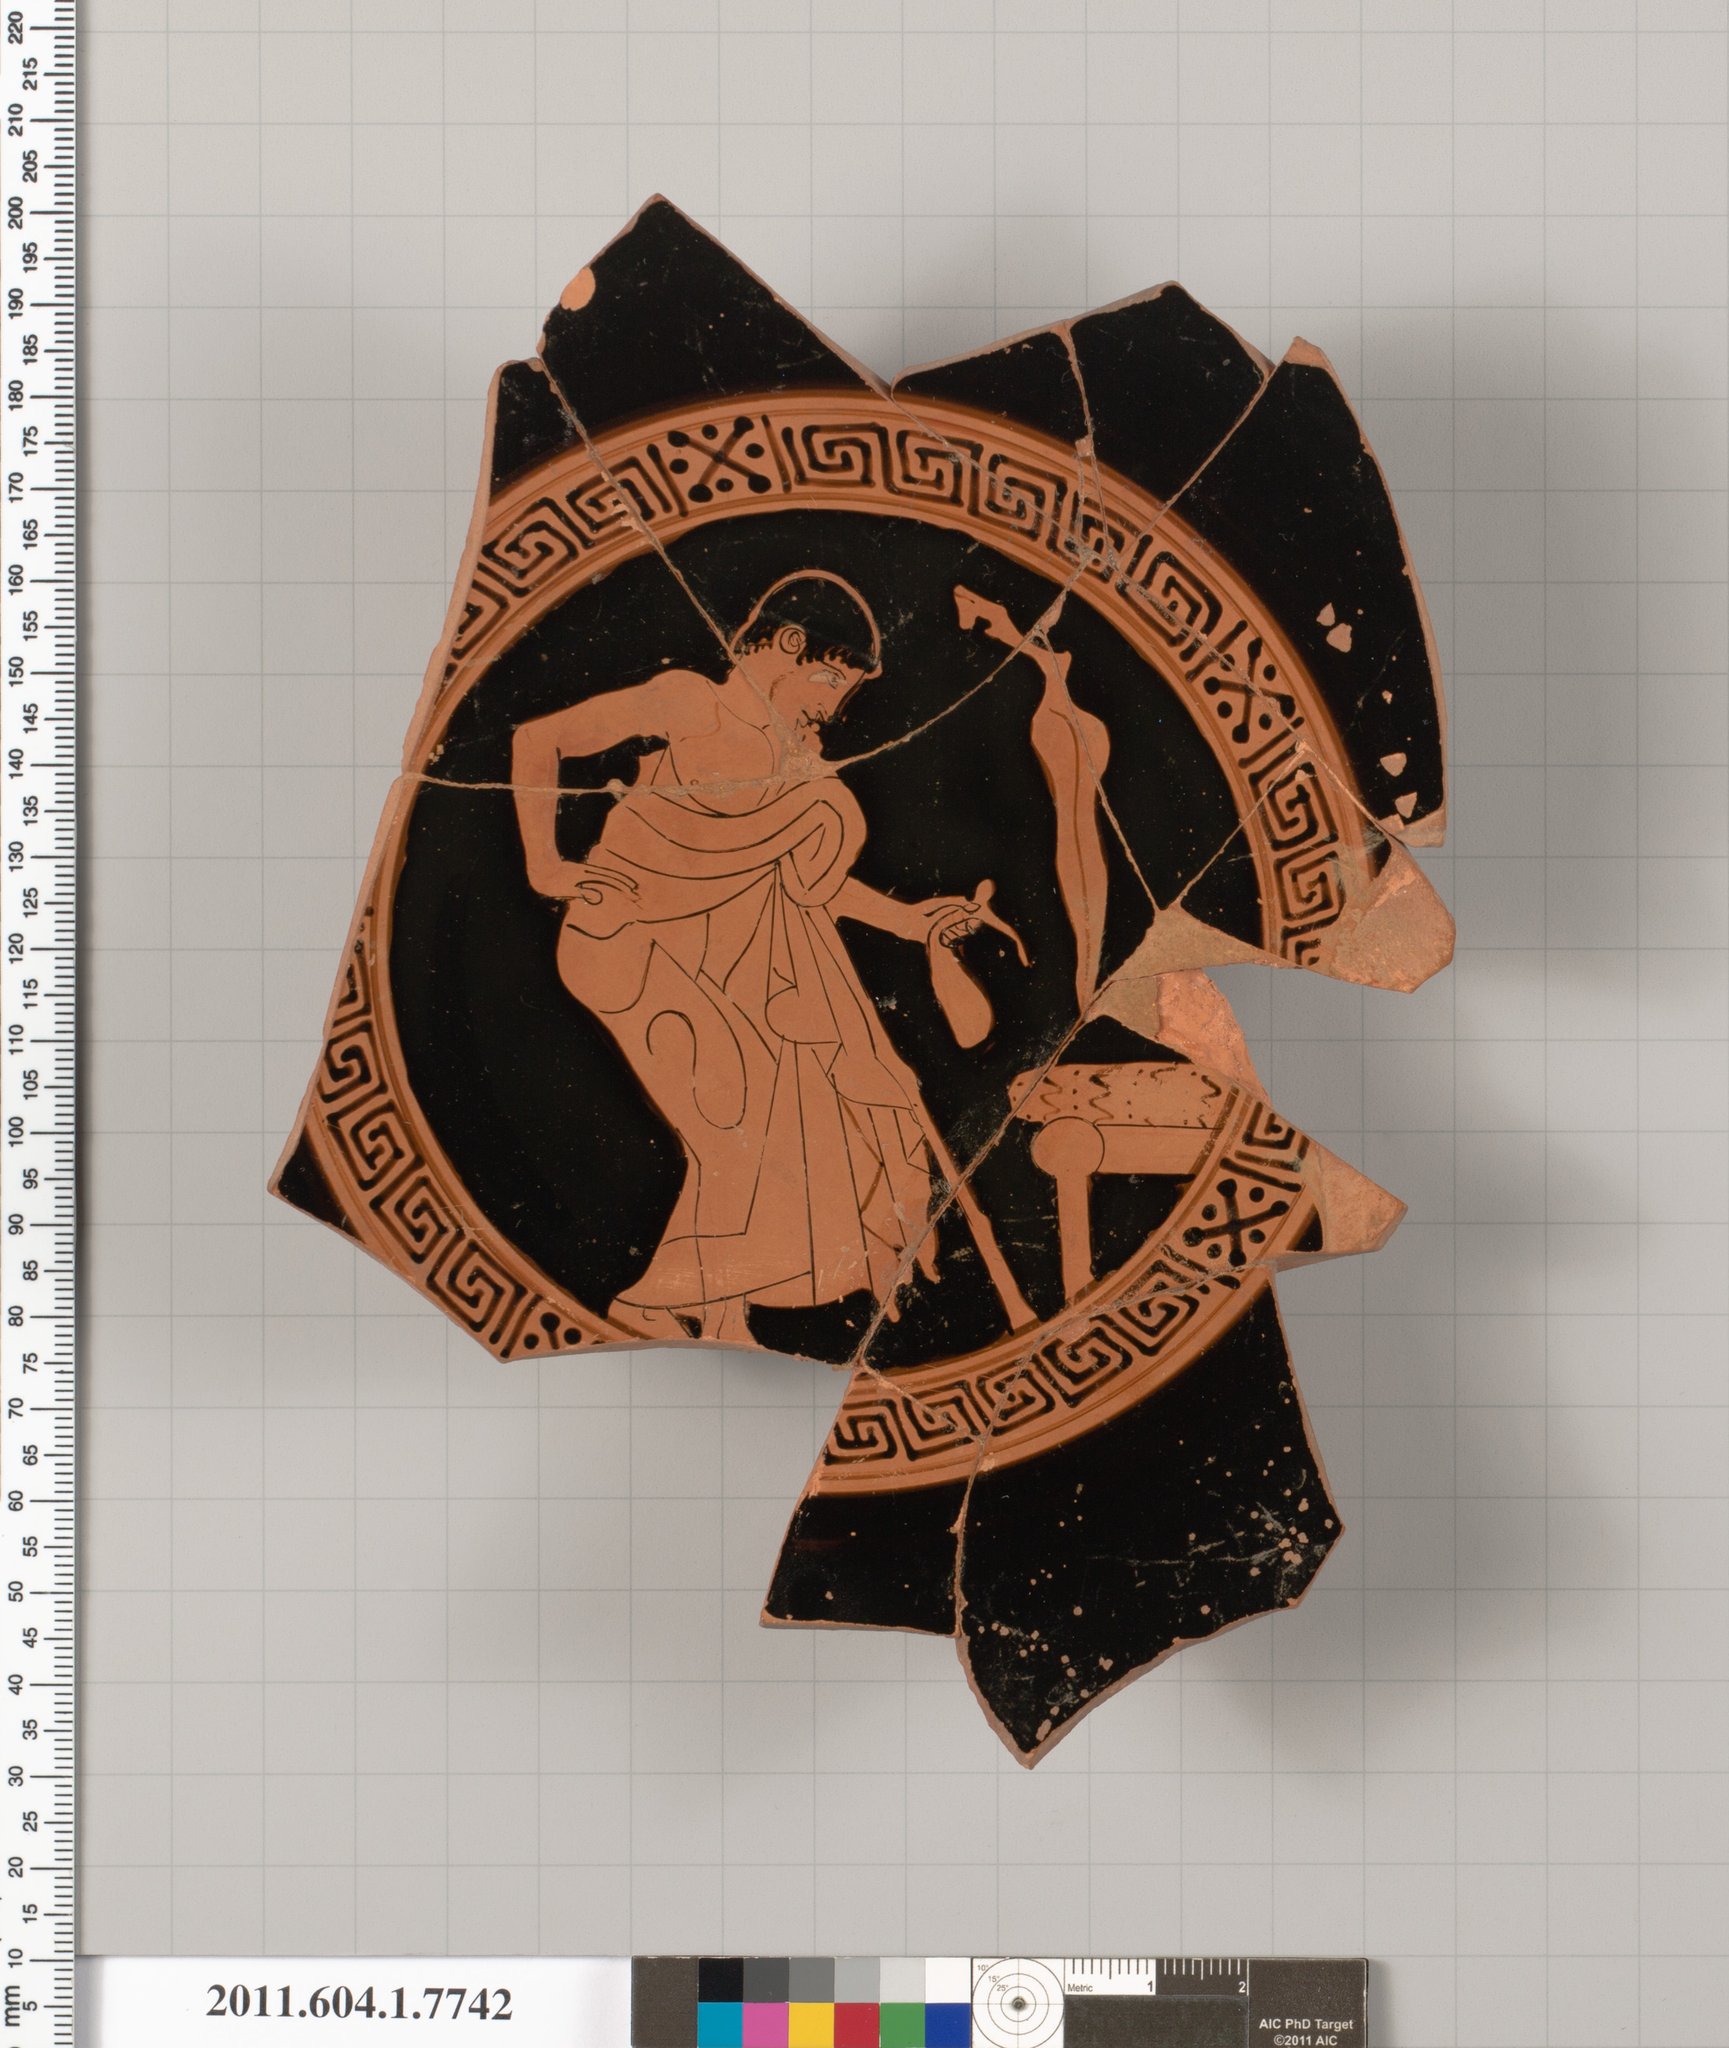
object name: kylix fragment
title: Terracotta fragment of a kylix (drinking cup)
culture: greek, attic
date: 460-450 BCE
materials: terracotta